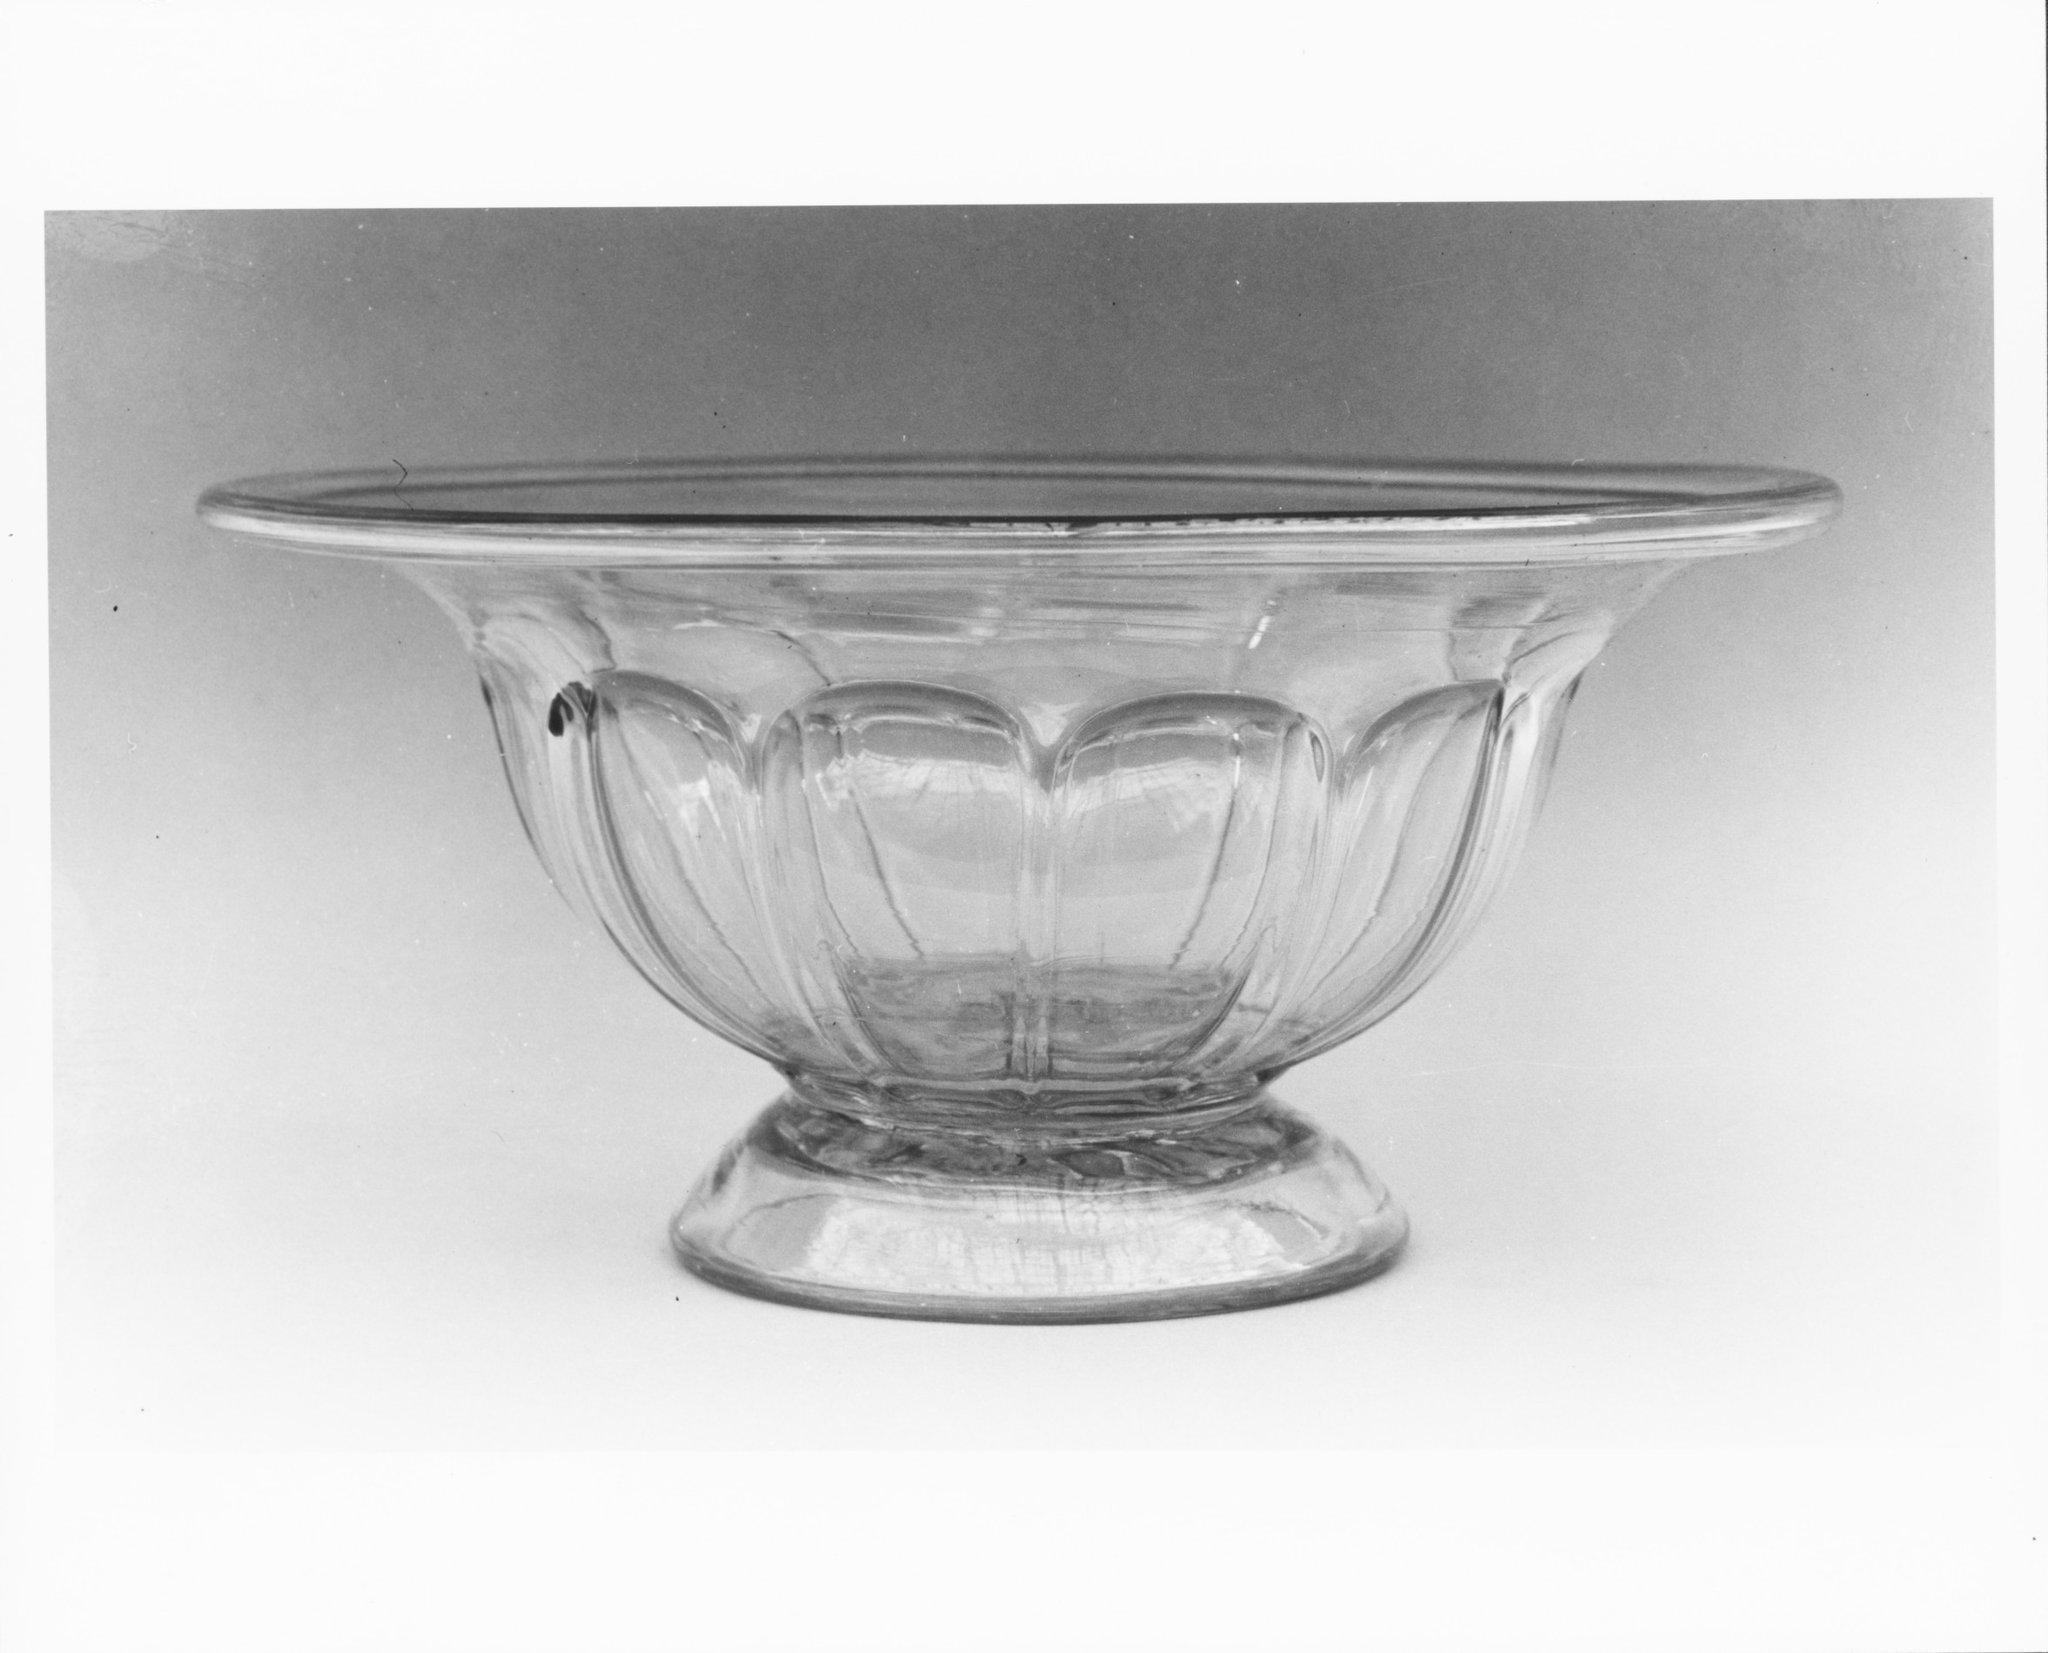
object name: bowl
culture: american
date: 1830-1850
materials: glass, lead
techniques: glassblowing, molding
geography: united states